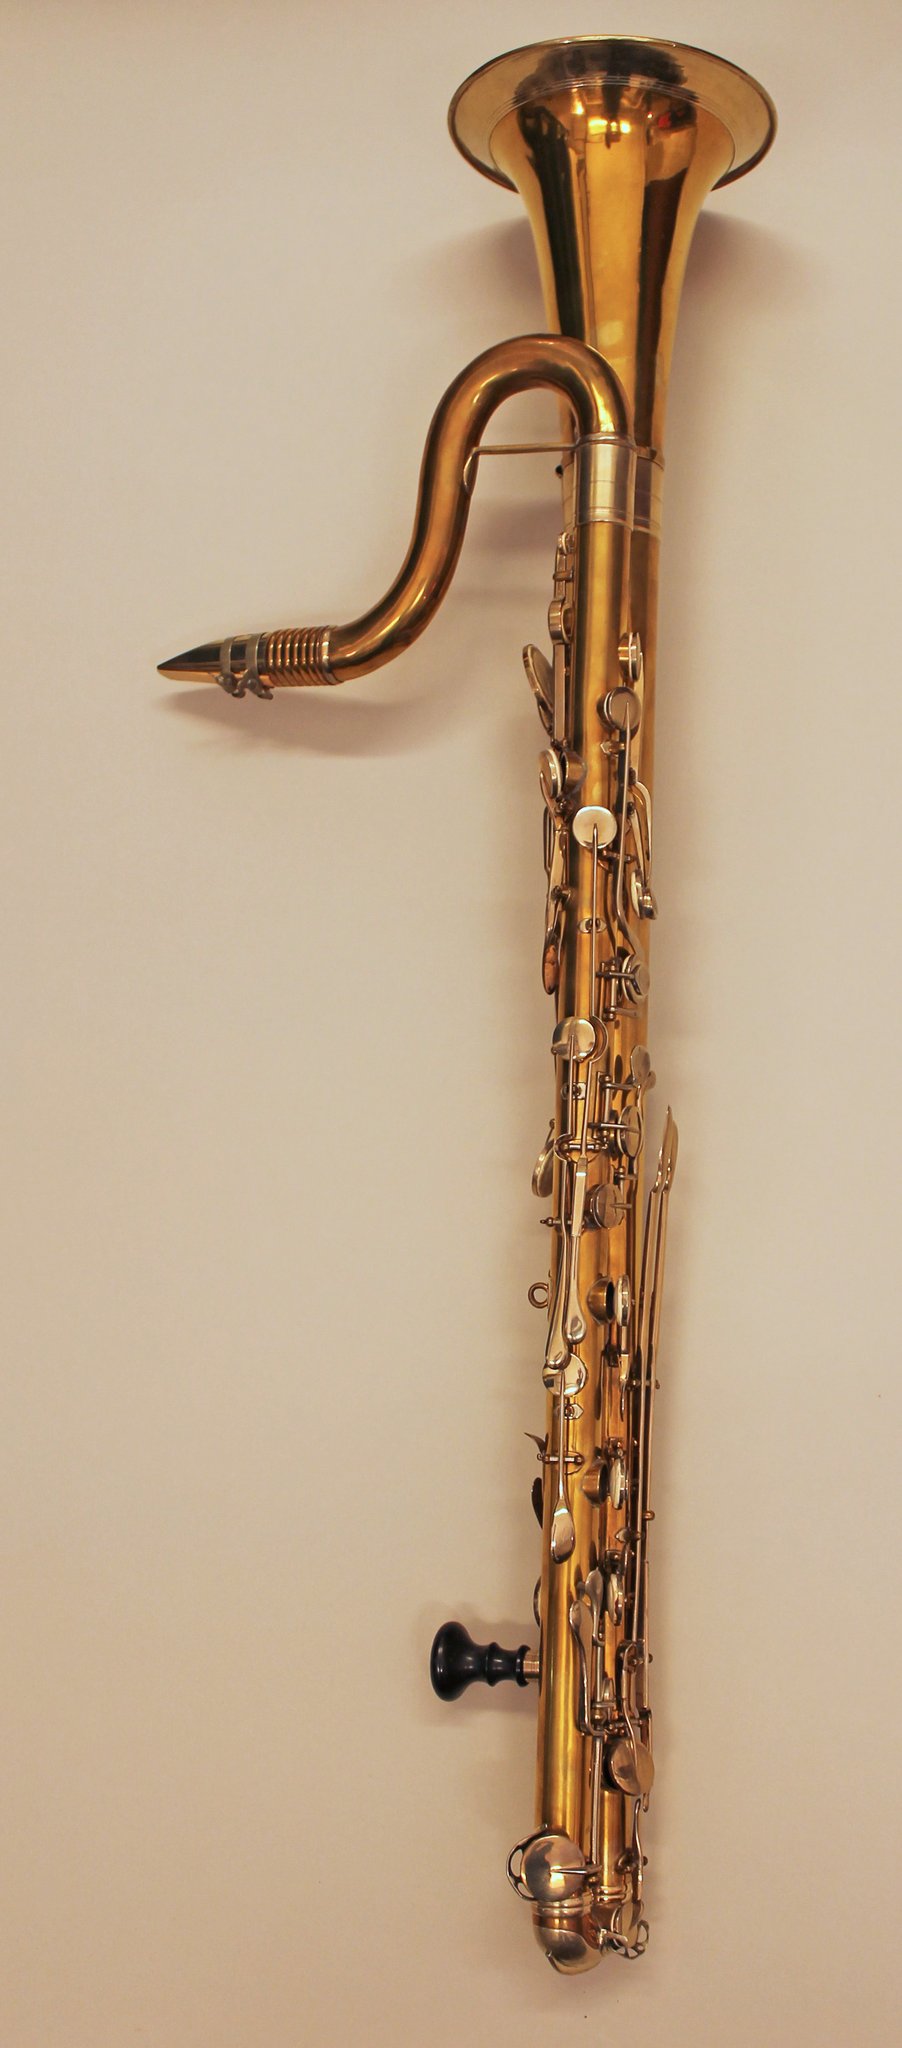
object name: clariofon bass clarinet n b flat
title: Clariofon Bass Clarinet in B-flat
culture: czech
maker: franz losschmidt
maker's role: maker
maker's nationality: czech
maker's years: 1852-1867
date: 1852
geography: czech republic